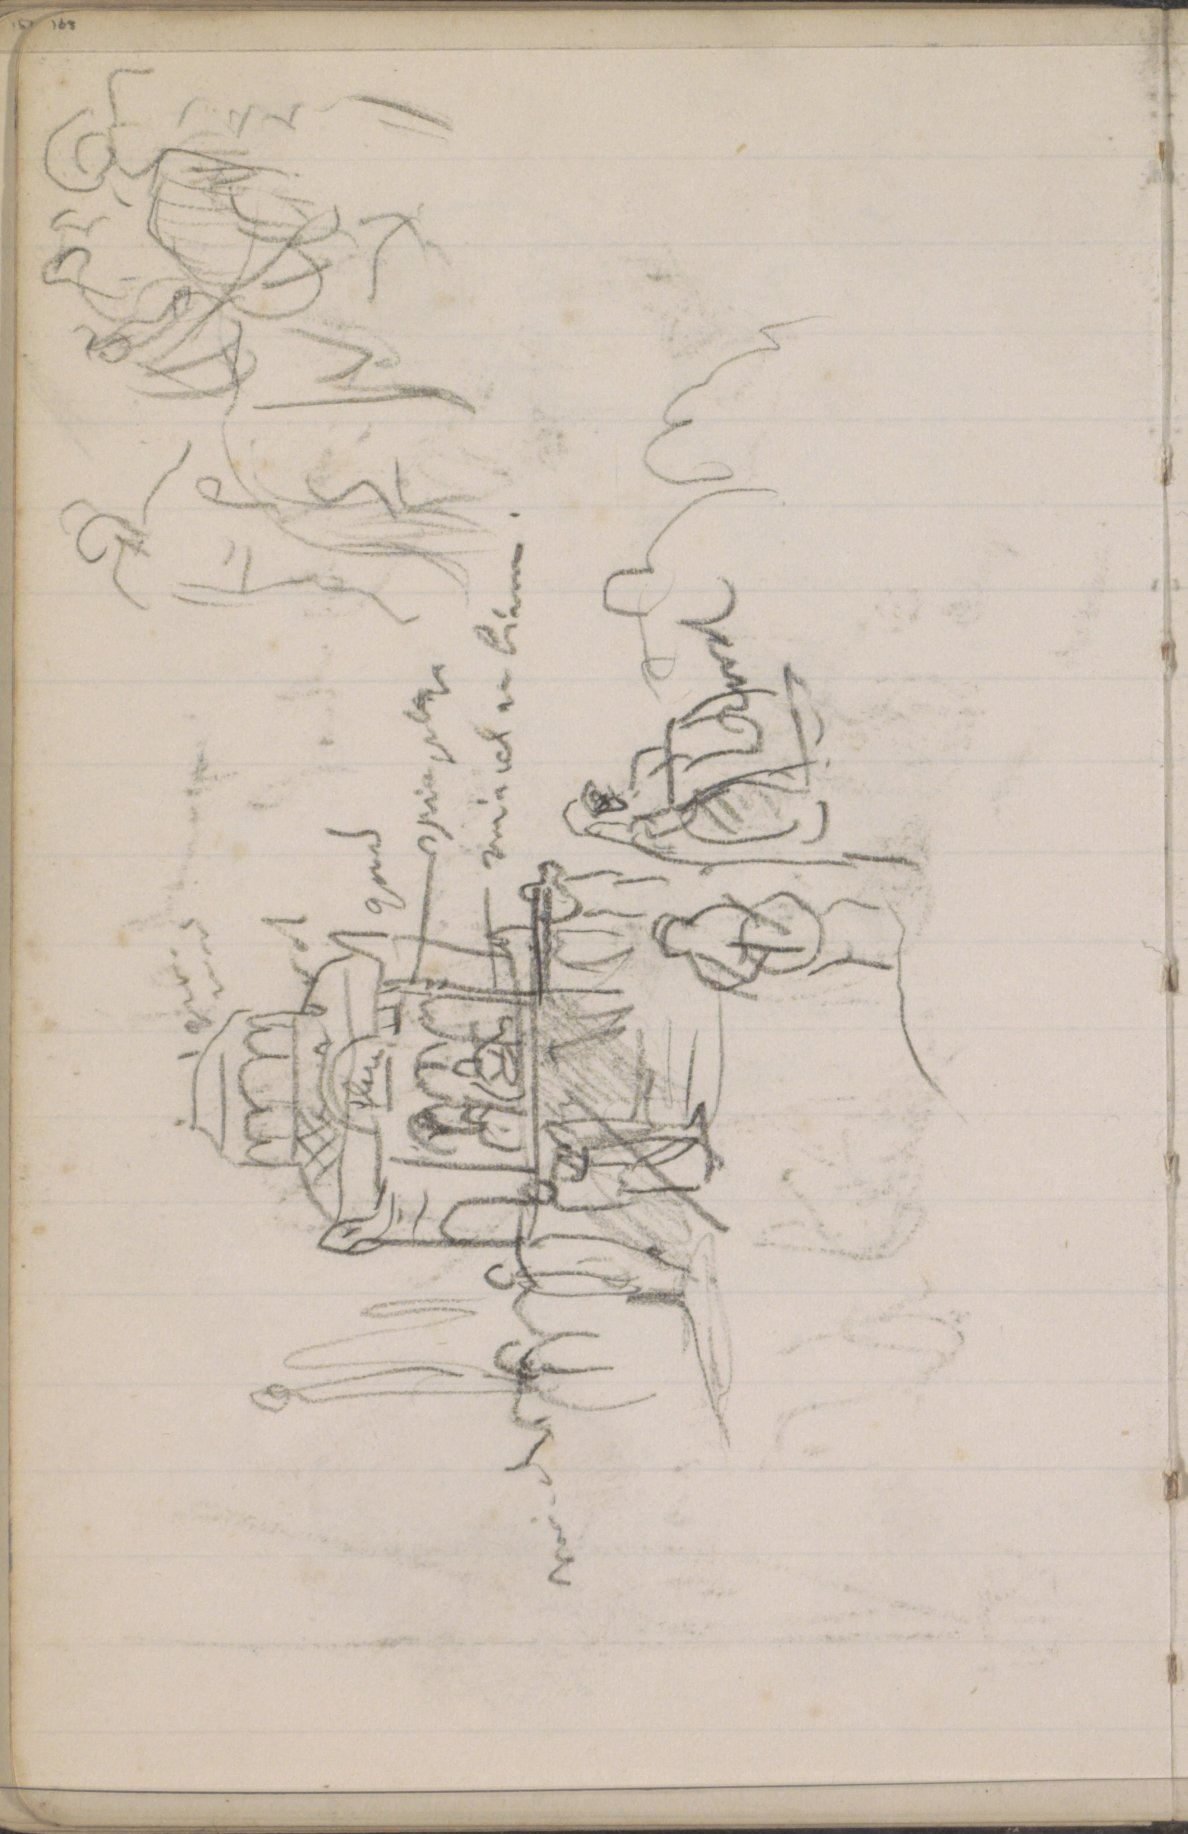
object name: sketchbook leaf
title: Bruiloftsoptocht met figuren die een palankijn dragen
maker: marius bauer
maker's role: draughtsman, print maker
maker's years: 1867-1932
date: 1897-1898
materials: chalk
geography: delhi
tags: riding a horse, ass, or mule; rider, horseman, groom (in wedding-dress), wedding feast, wedding meal, (carrying a person in a) sedan-chair, carrying something on the head or on the shoulders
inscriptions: kleurnotitie, handgeschreven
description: De palankijn is in de vorm van een pagode. Pagina 163 uit een schetsboek met 84 bladen.